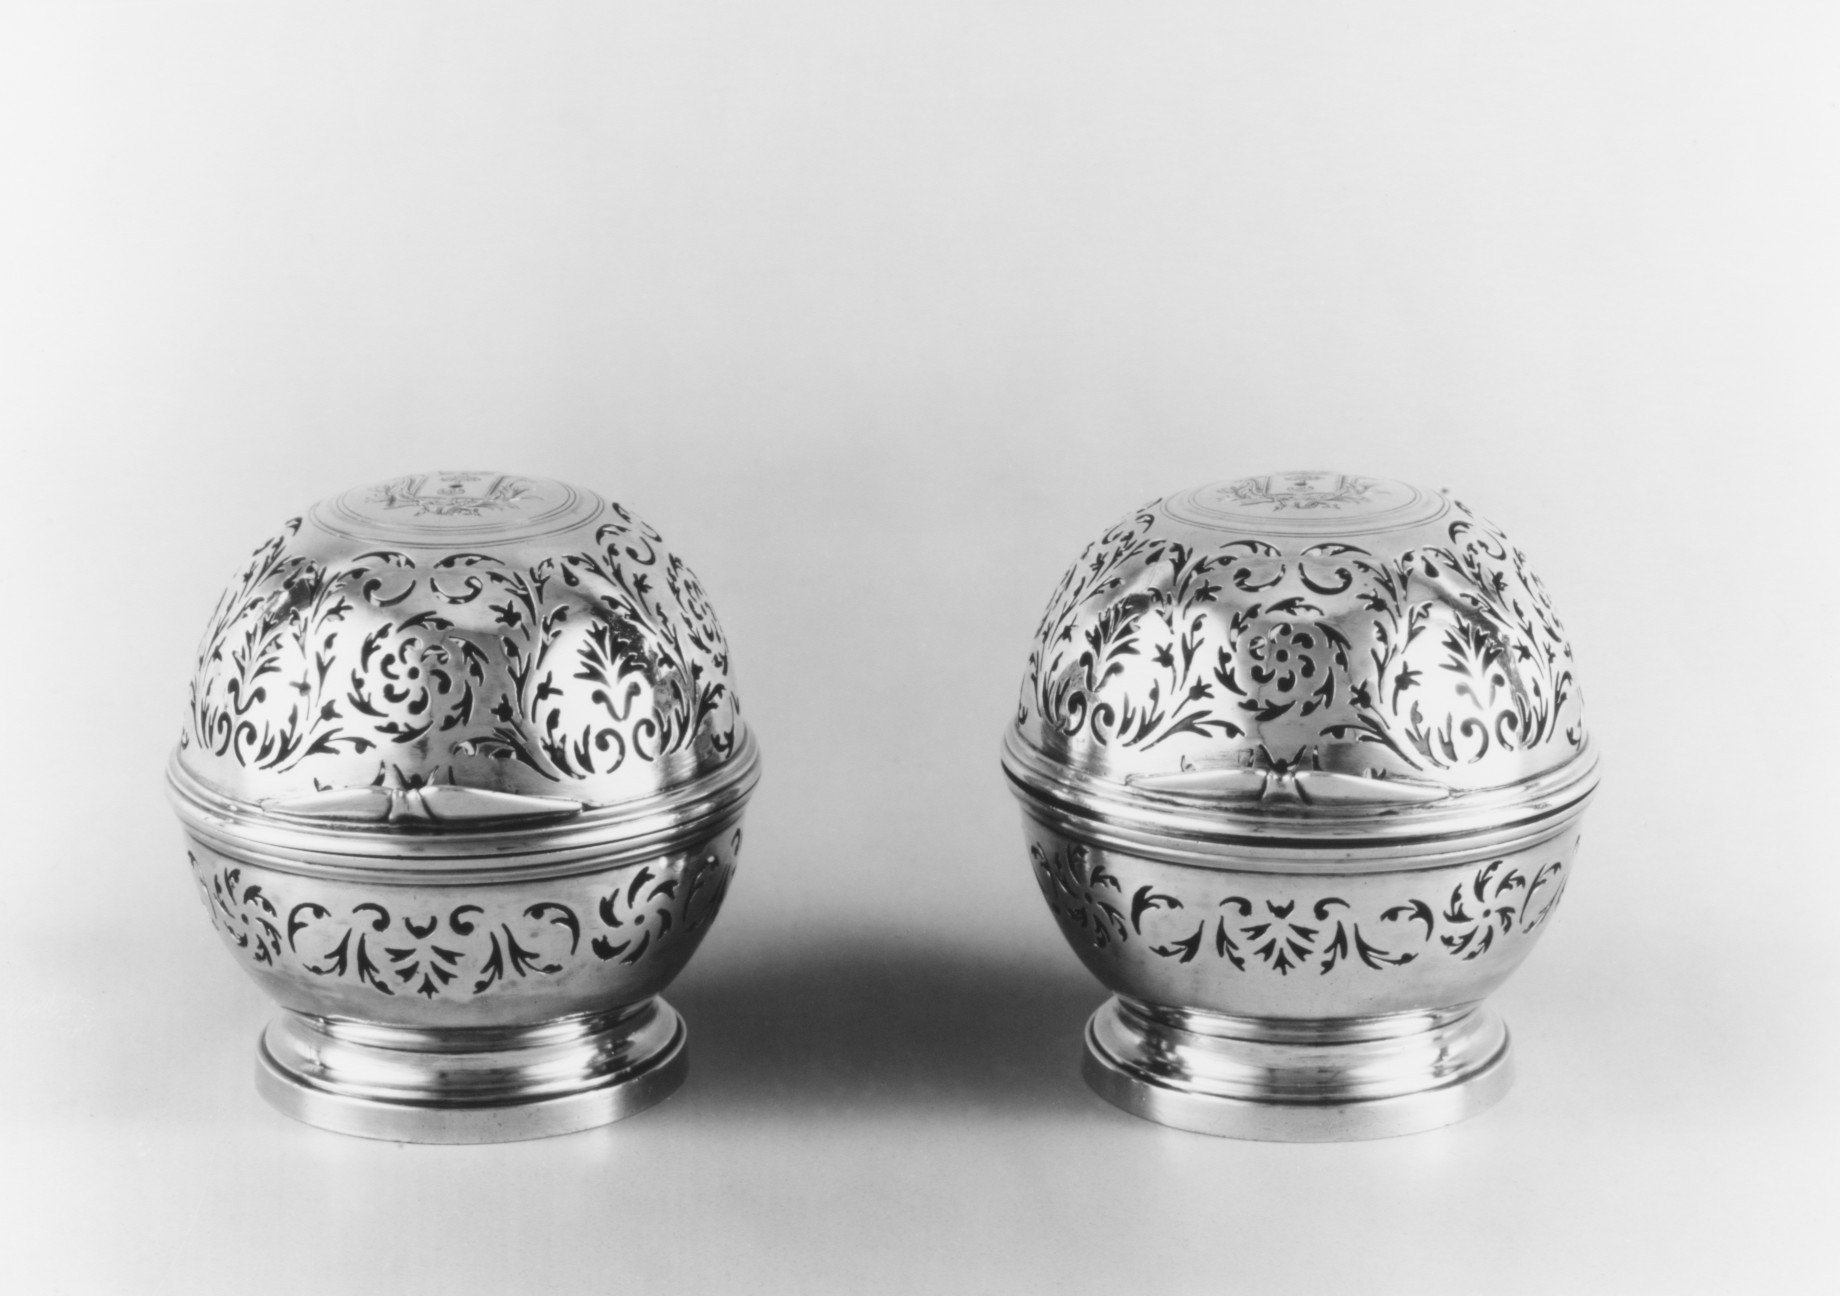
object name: sponge box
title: Pair of sponge boxes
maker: claude-pierre deville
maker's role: maker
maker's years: 1739-1813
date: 1775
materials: silver